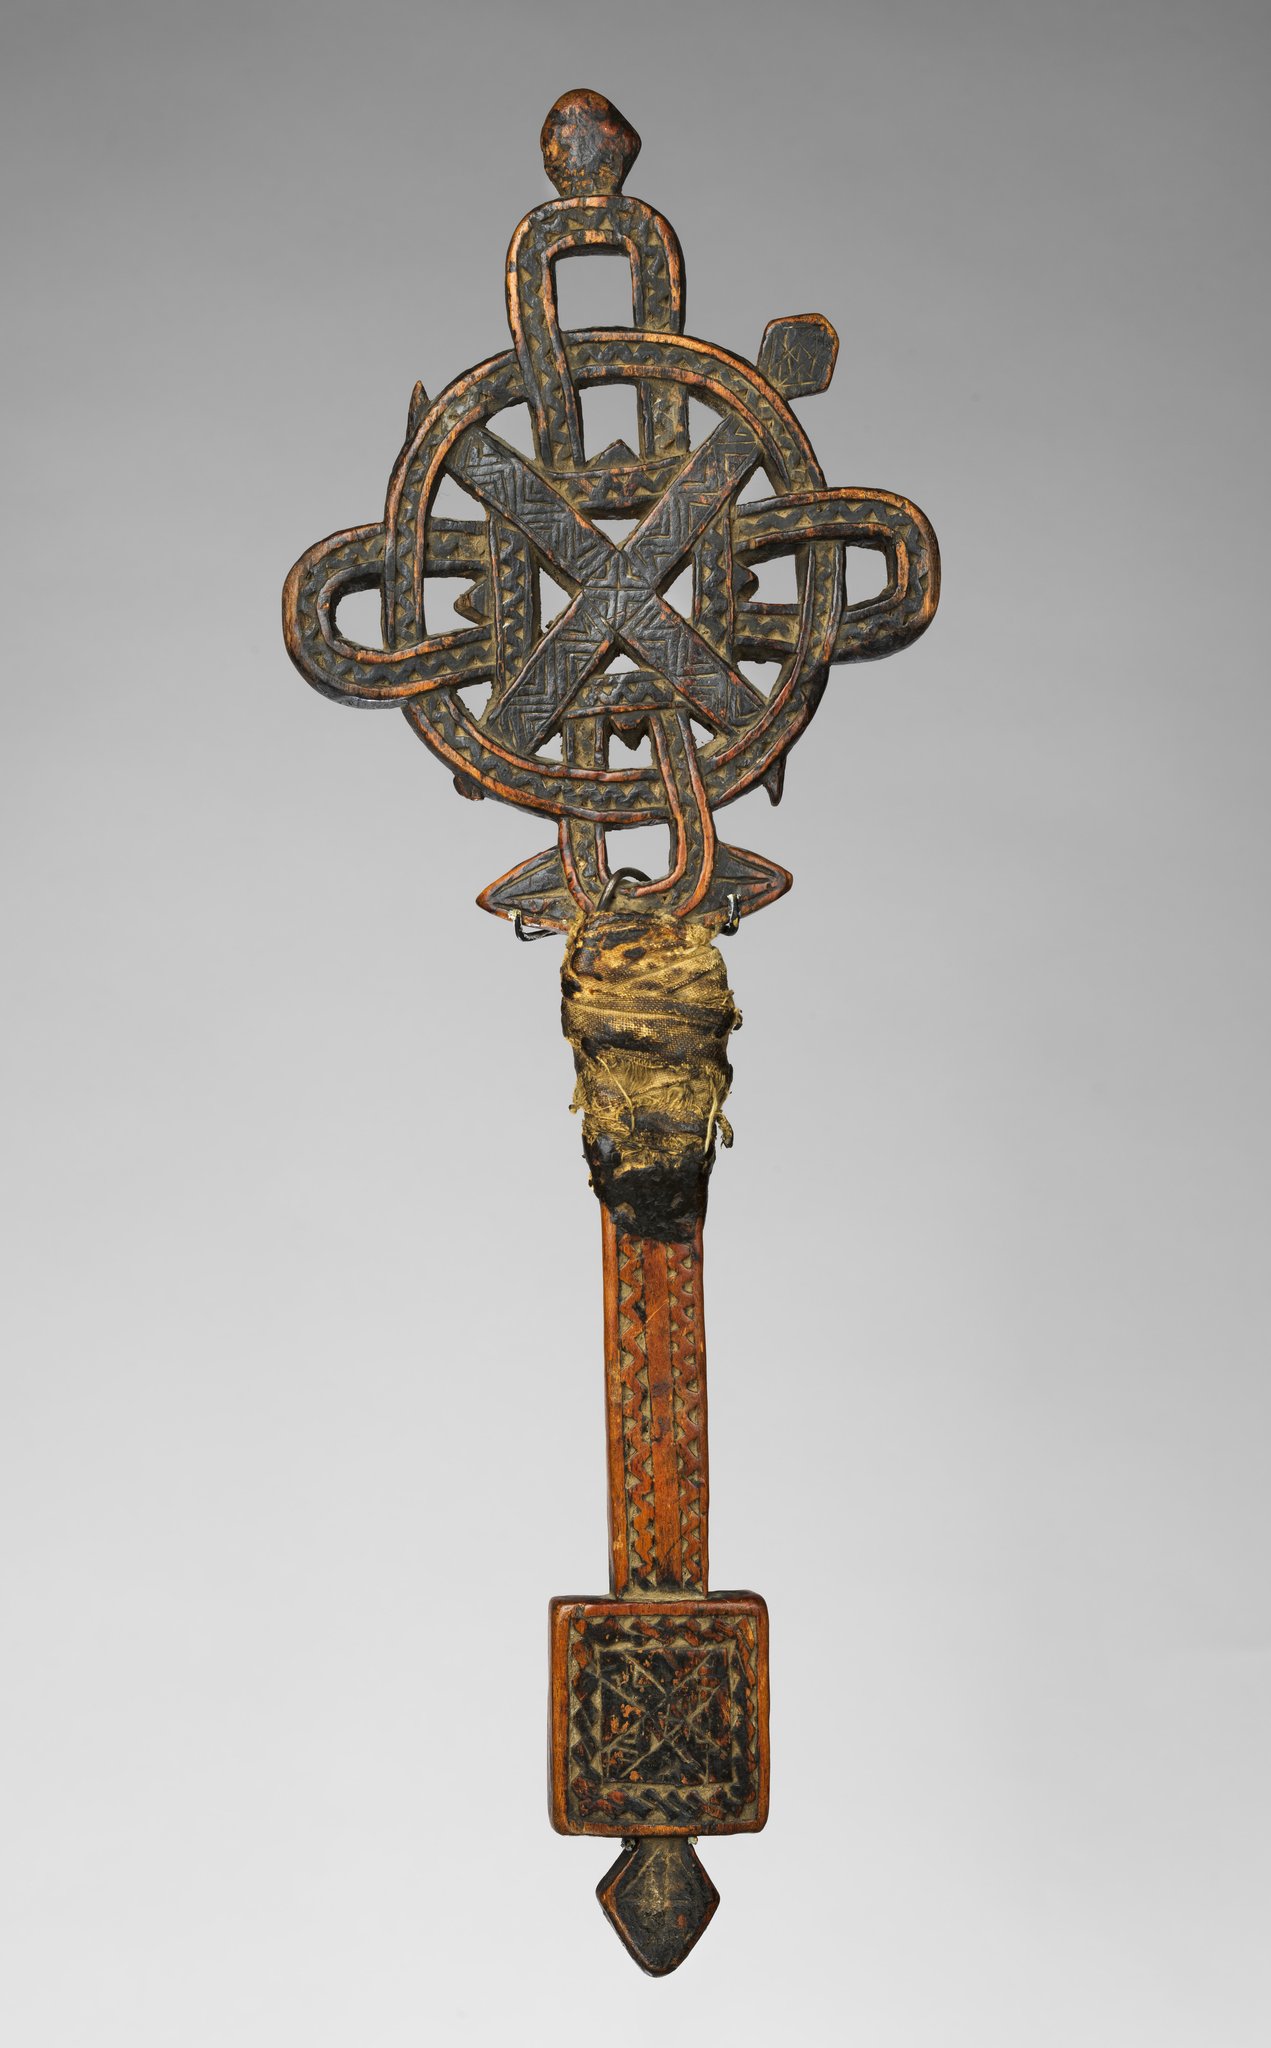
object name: cross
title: Hand Cross (mäsqäl)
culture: amhara or tigrinya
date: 1701-1800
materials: wood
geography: ethiopia